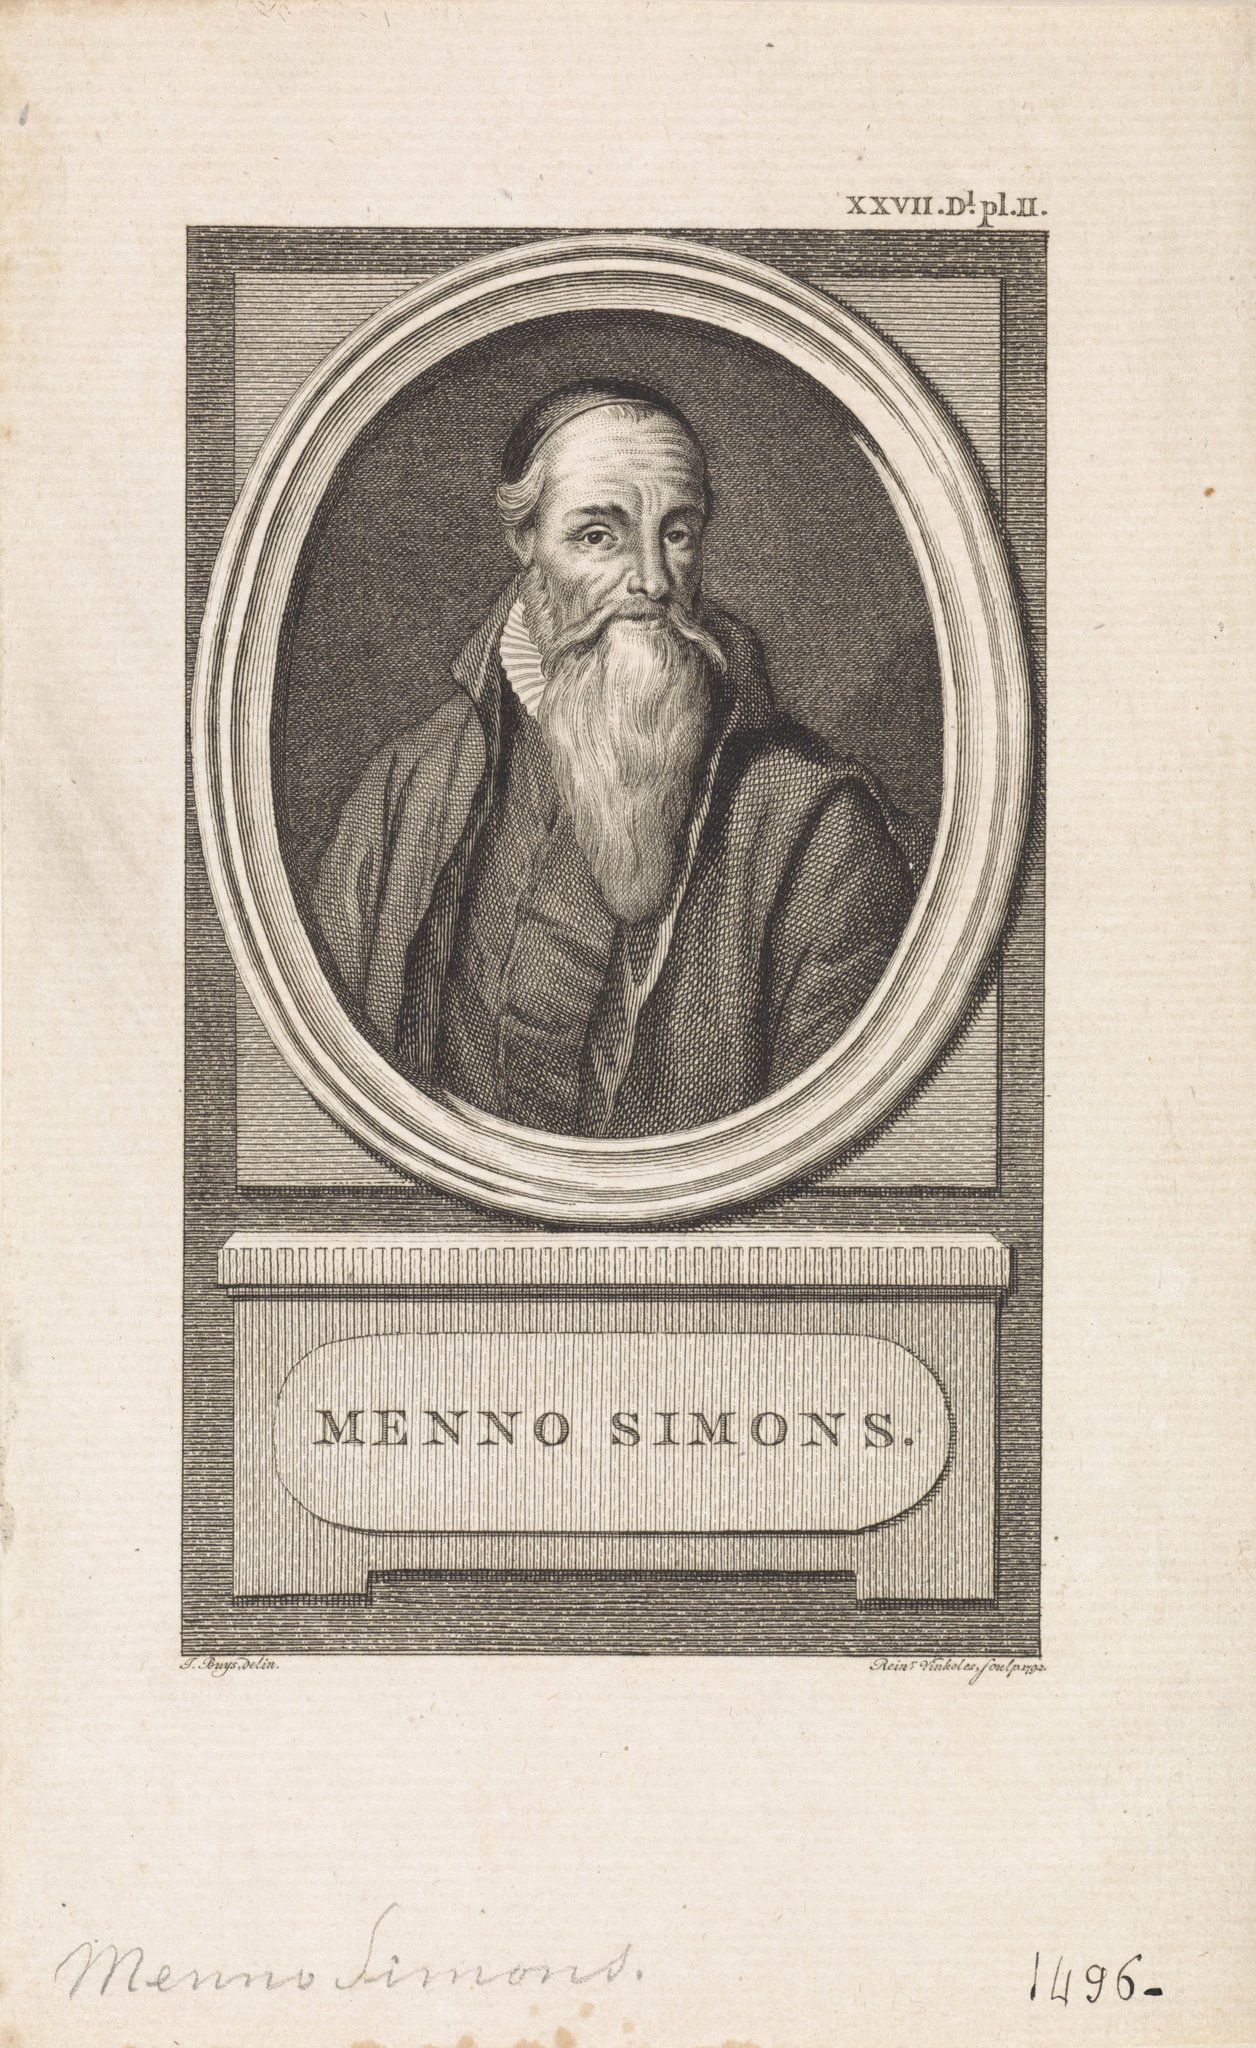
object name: book illustration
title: Portret van Menno Simons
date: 1792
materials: paper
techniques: engraving, etching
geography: amsterdam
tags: clergyman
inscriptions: number: ‘1496’, collector's mark: Lugt 2228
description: Prent gebruikt als boekillustratie in: Kok, Jacobus. Vaderlandsch woordenboek : met kaarten, plaaten en pourtraitten. Amsterdam: Johannes Allart, 1785-1796. Deel XXVII.